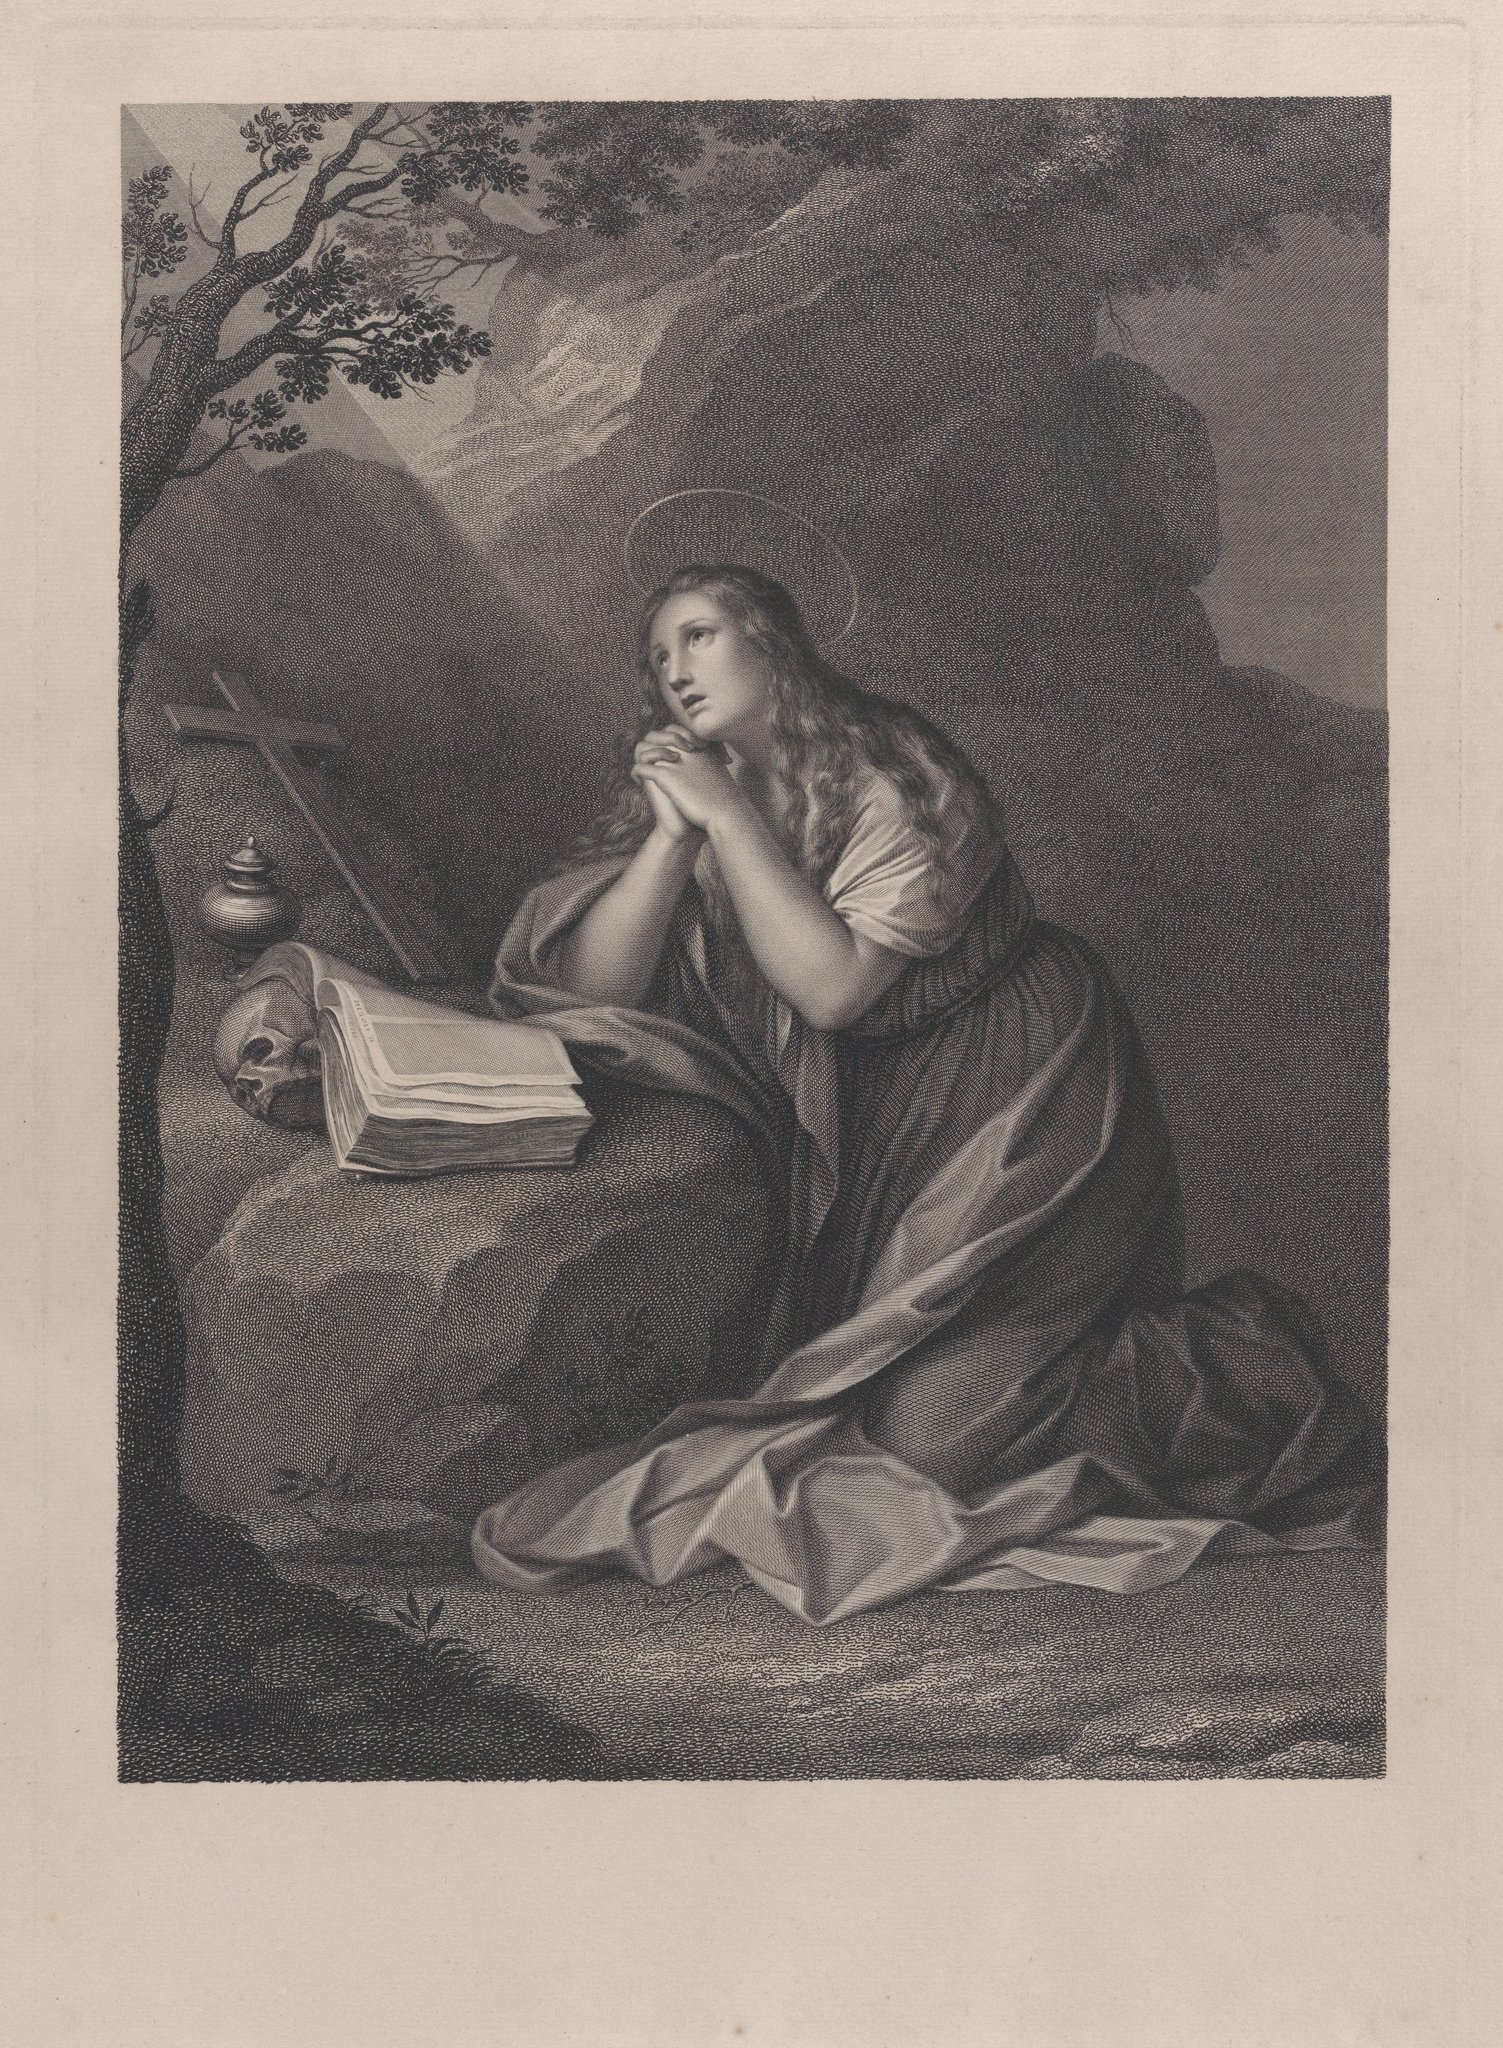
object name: print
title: Mary Magdalene, penitent in the desert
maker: raphael morghen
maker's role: artist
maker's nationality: italian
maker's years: 1758-1833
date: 1801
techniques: engraving